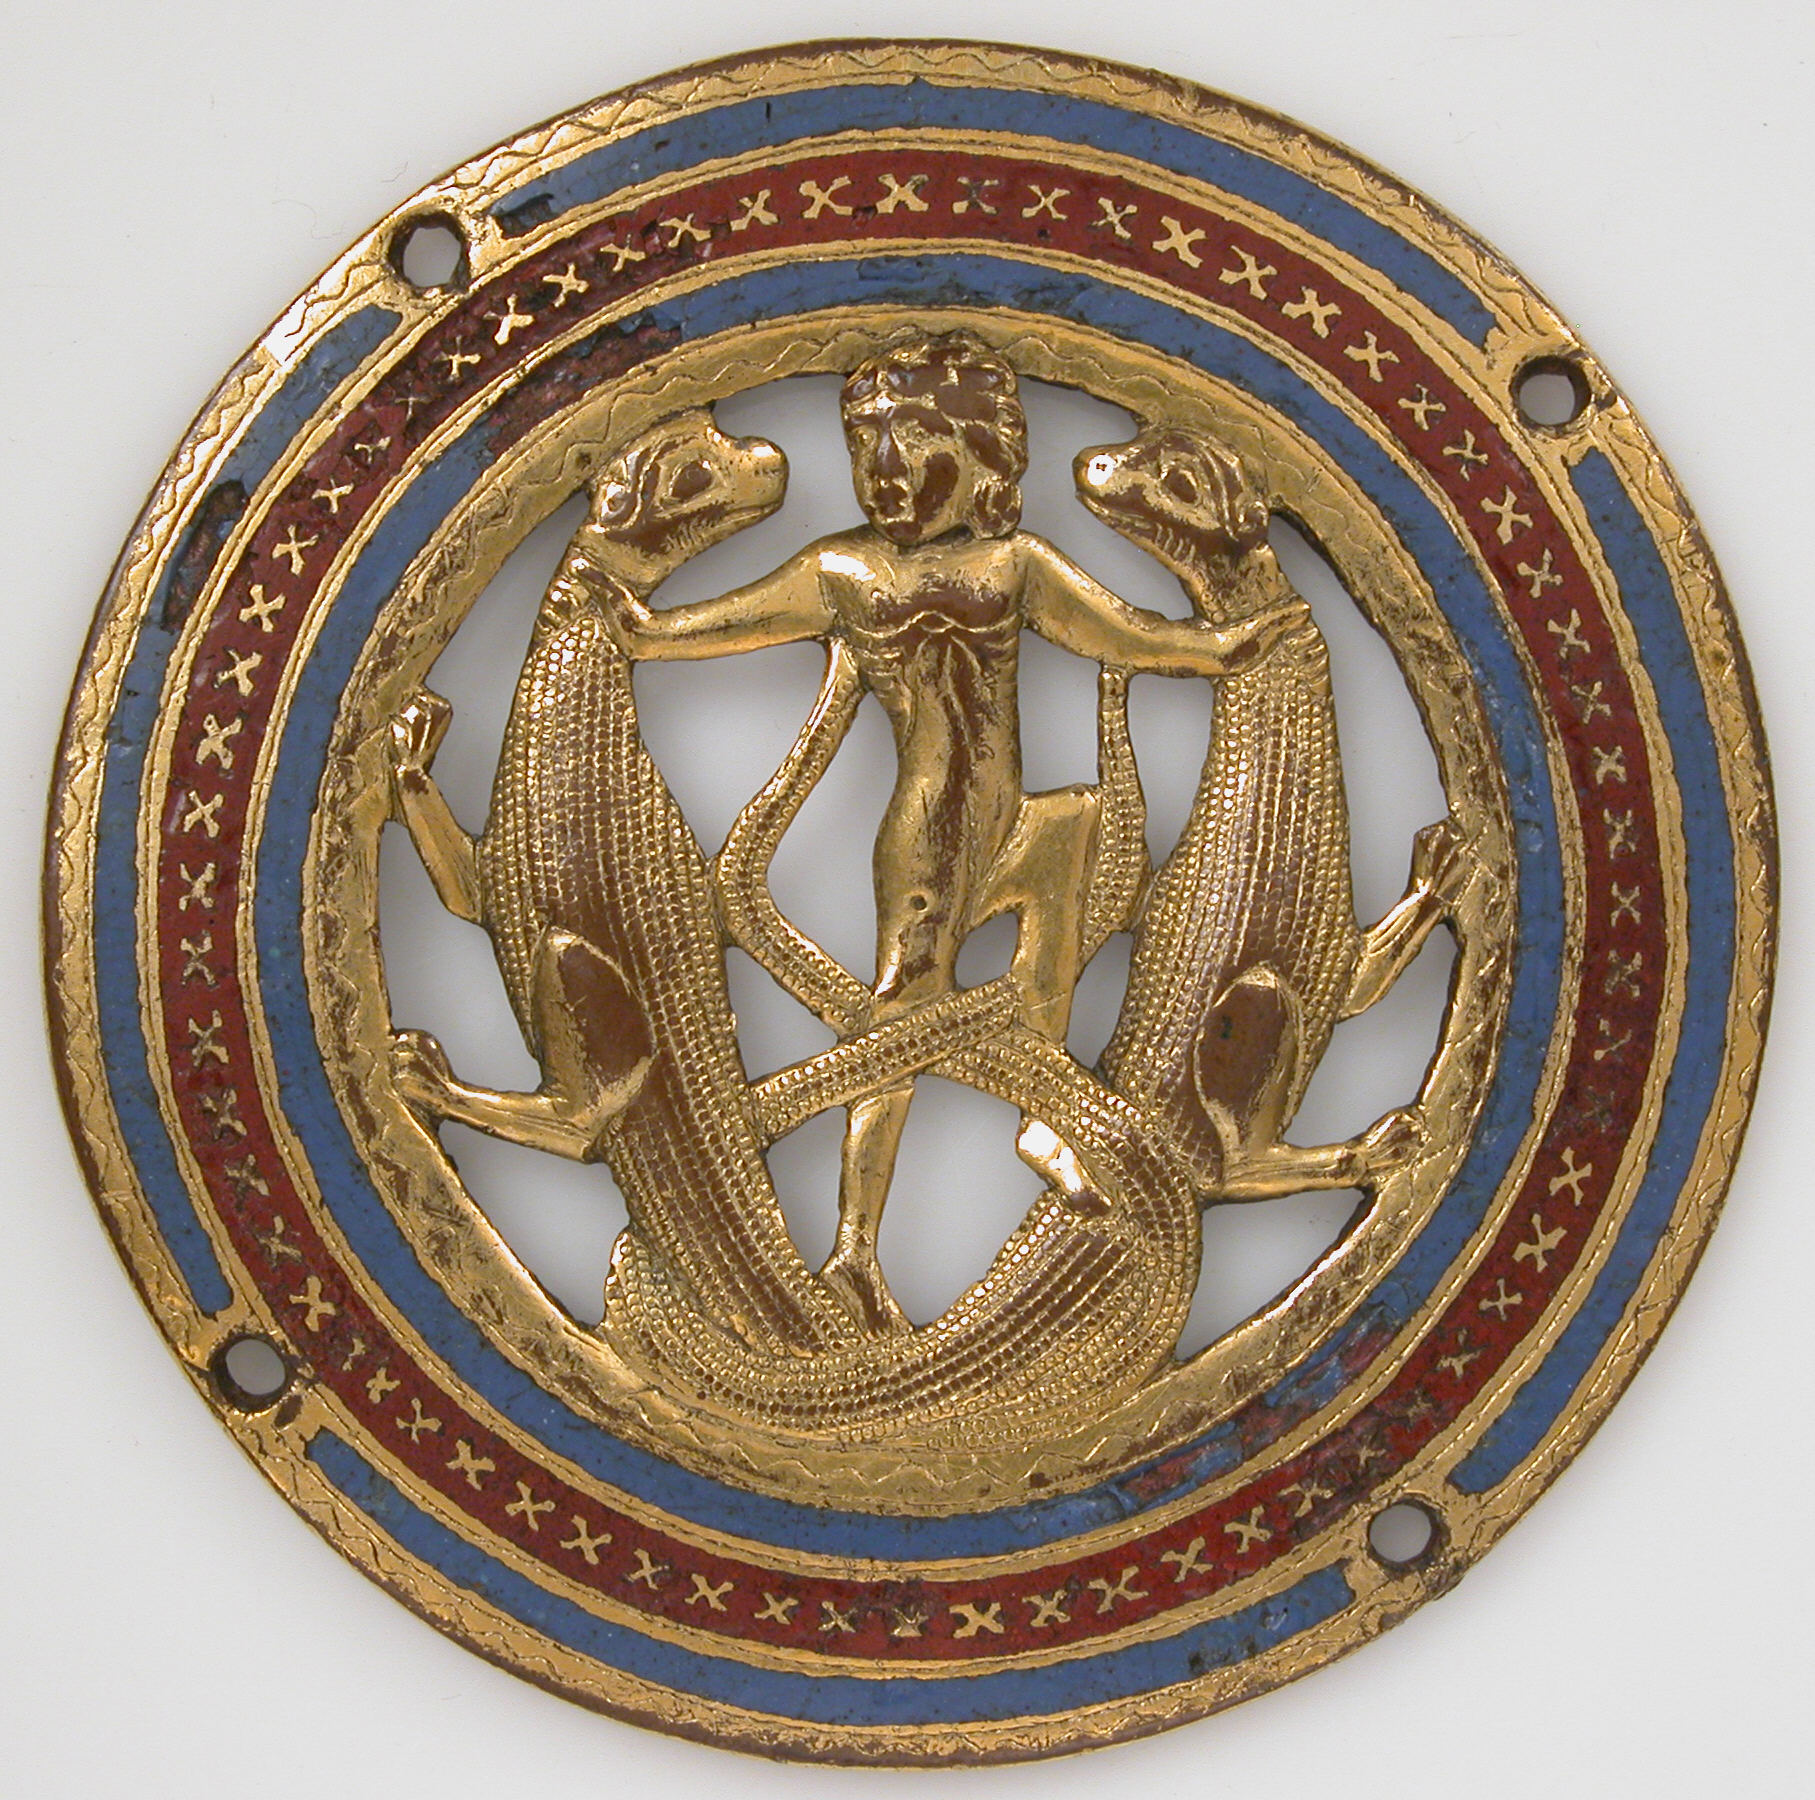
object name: medallion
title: Medallion from a Coffret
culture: french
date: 1210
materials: copper, enamel, gilt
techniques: enamel, chasing, engraving, repoussé, stamping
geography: france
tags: men,dragons